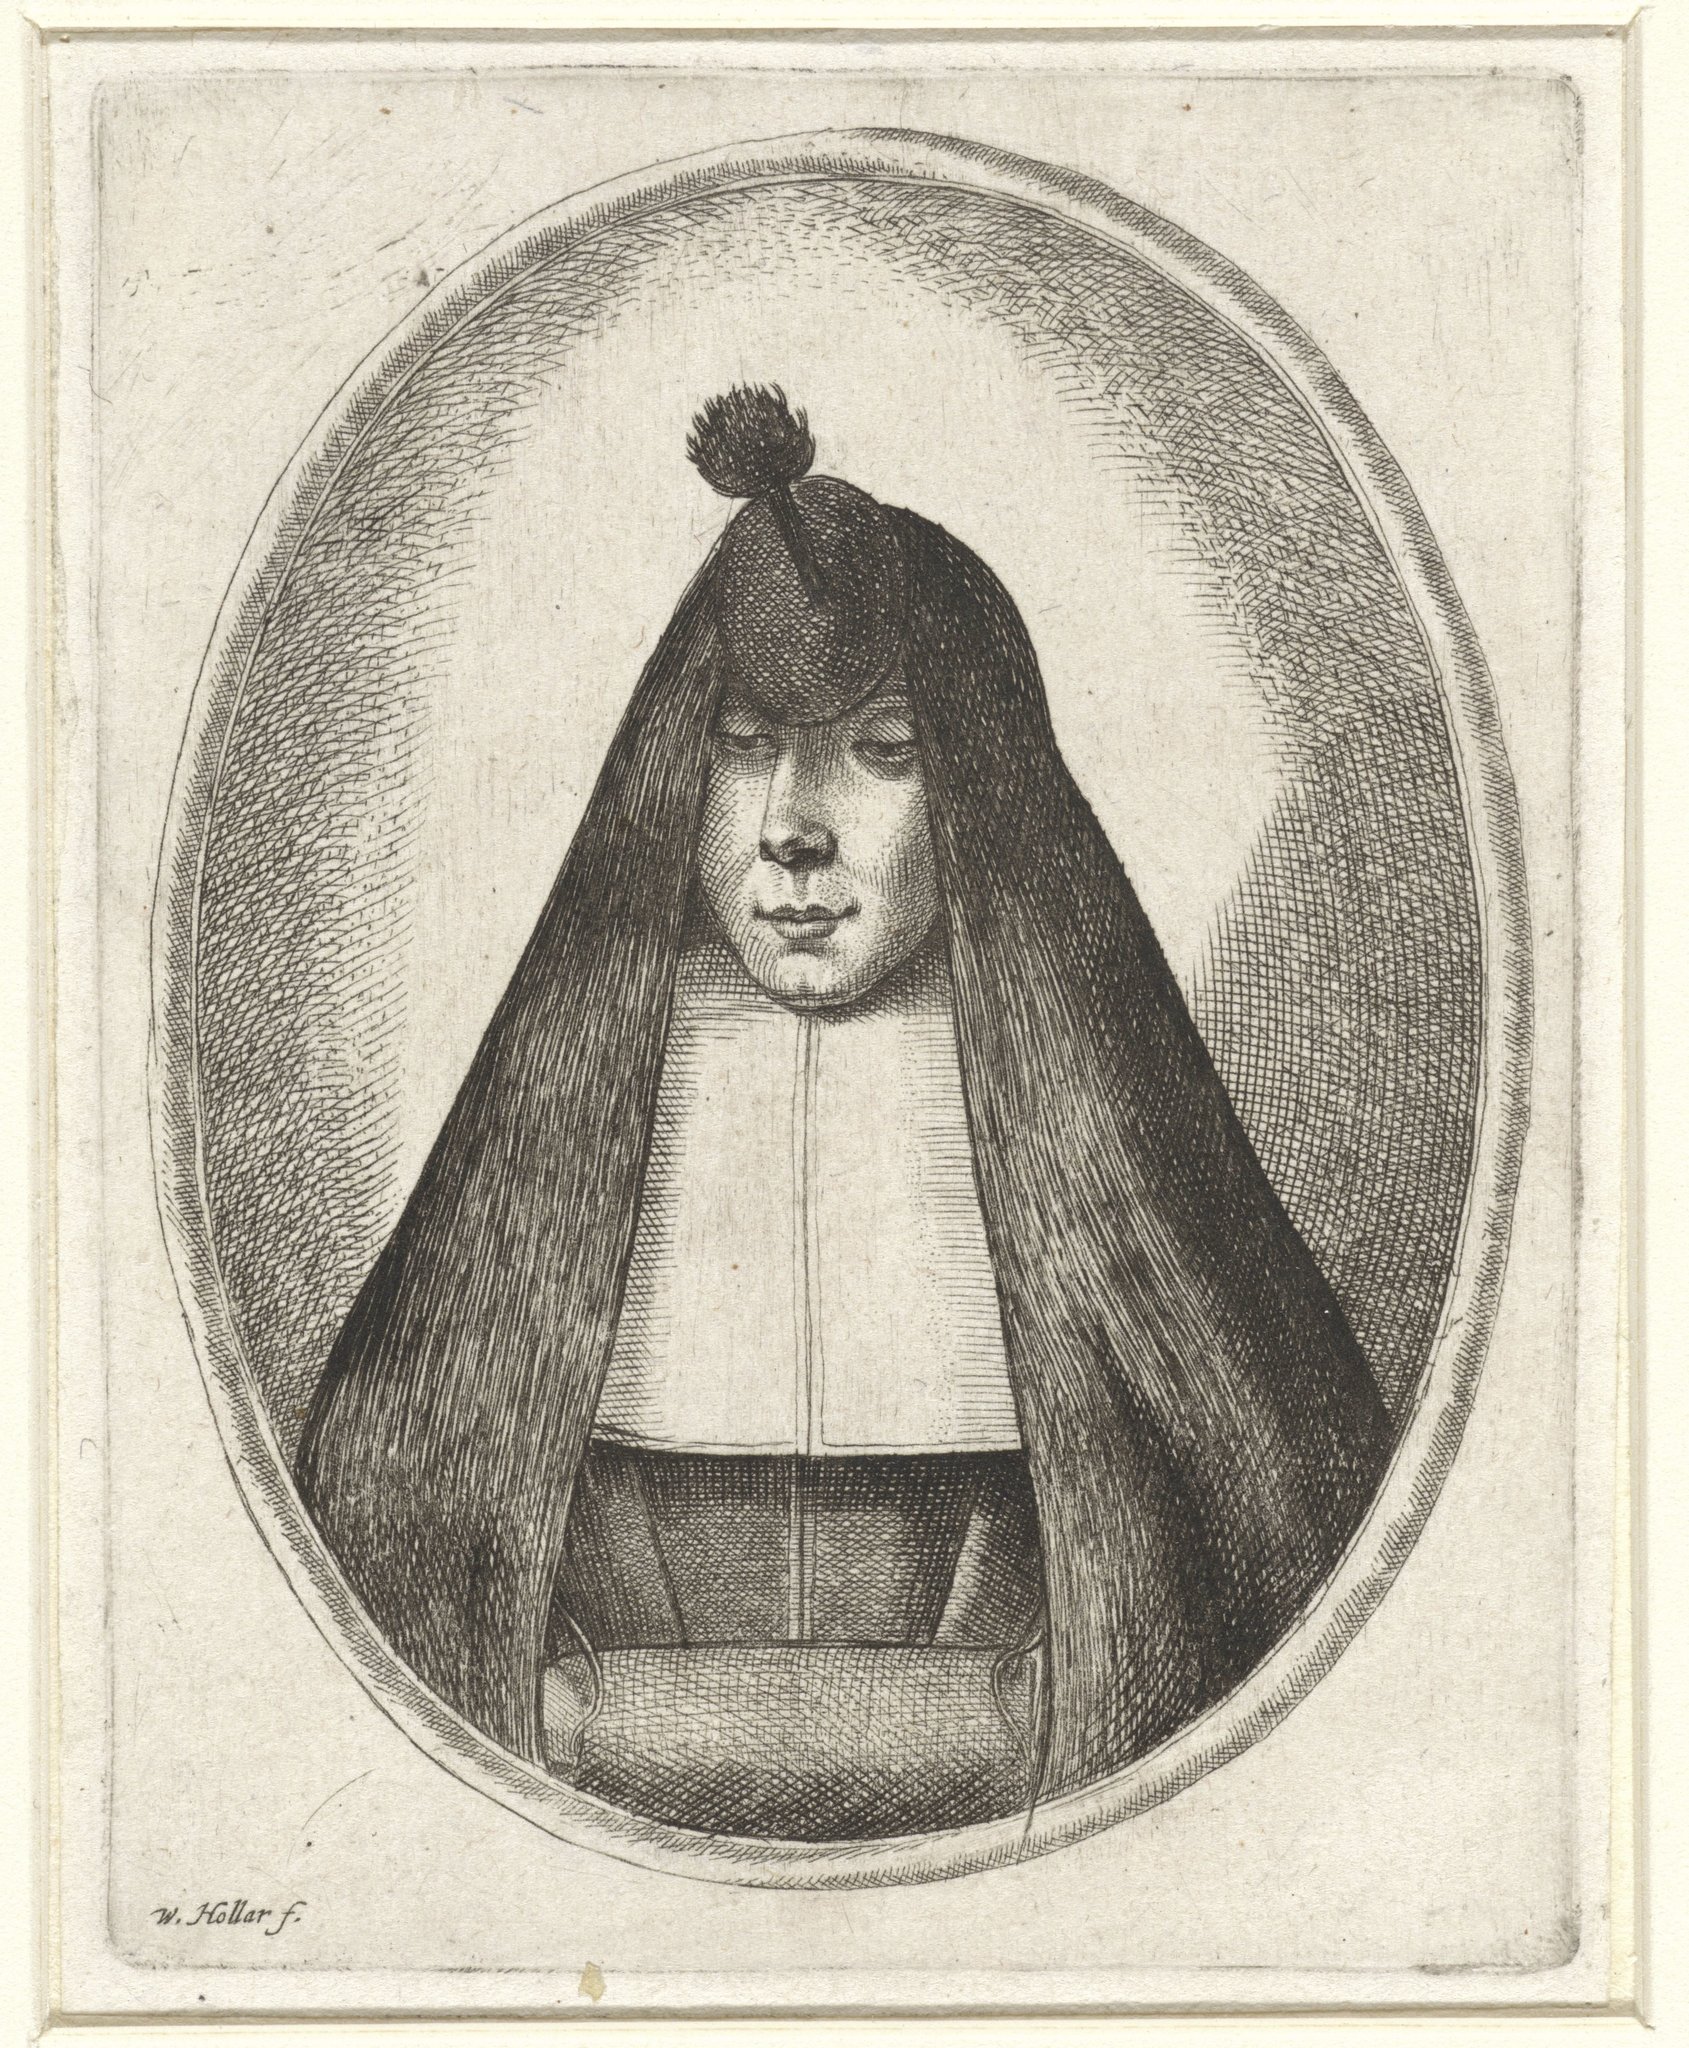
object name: print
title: Portret van een vrouw met houpette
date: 1625-1727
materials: paper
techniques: etching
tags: anonymous historical person portrayed alone - bb - woman, head-gear (houpette)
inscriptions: collector's mark: Lugt 2542, collector's mark: Lugt 654